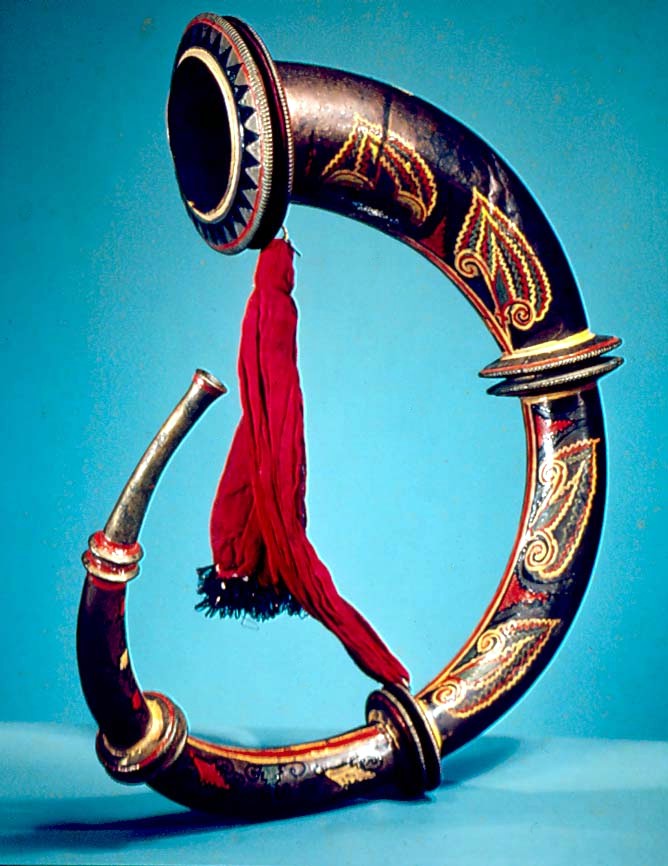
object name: ranasringa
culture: indian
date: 1880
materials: metal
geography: india